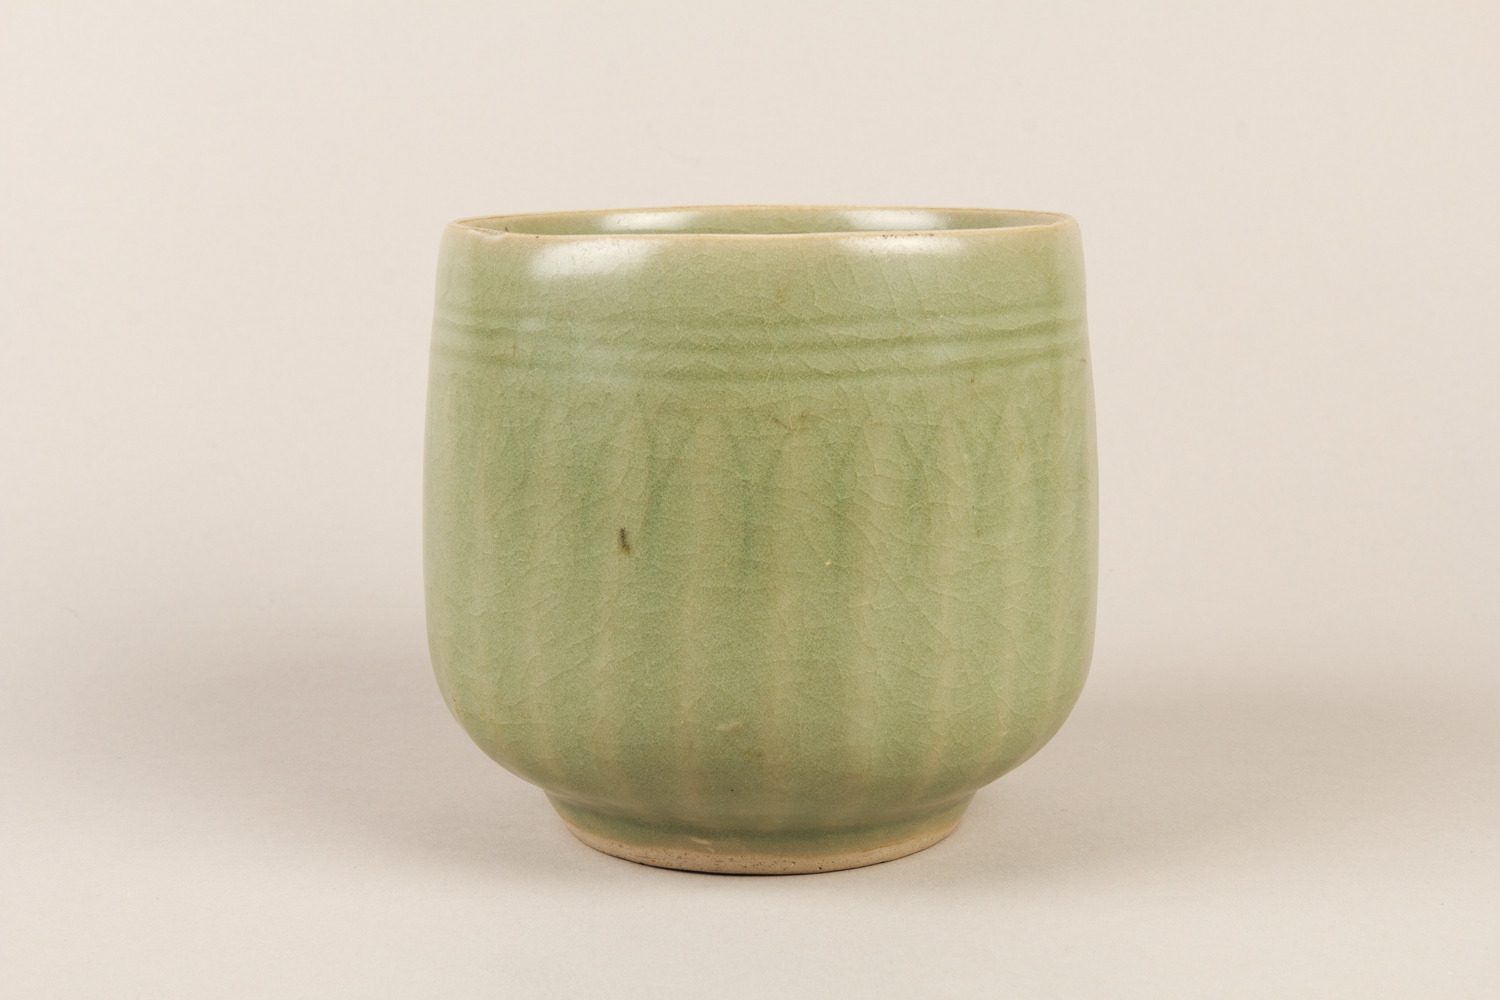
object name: bowl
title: Lotus Bowl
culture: vietnamese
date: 1301-1400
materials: ceramic, glaze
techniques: firing